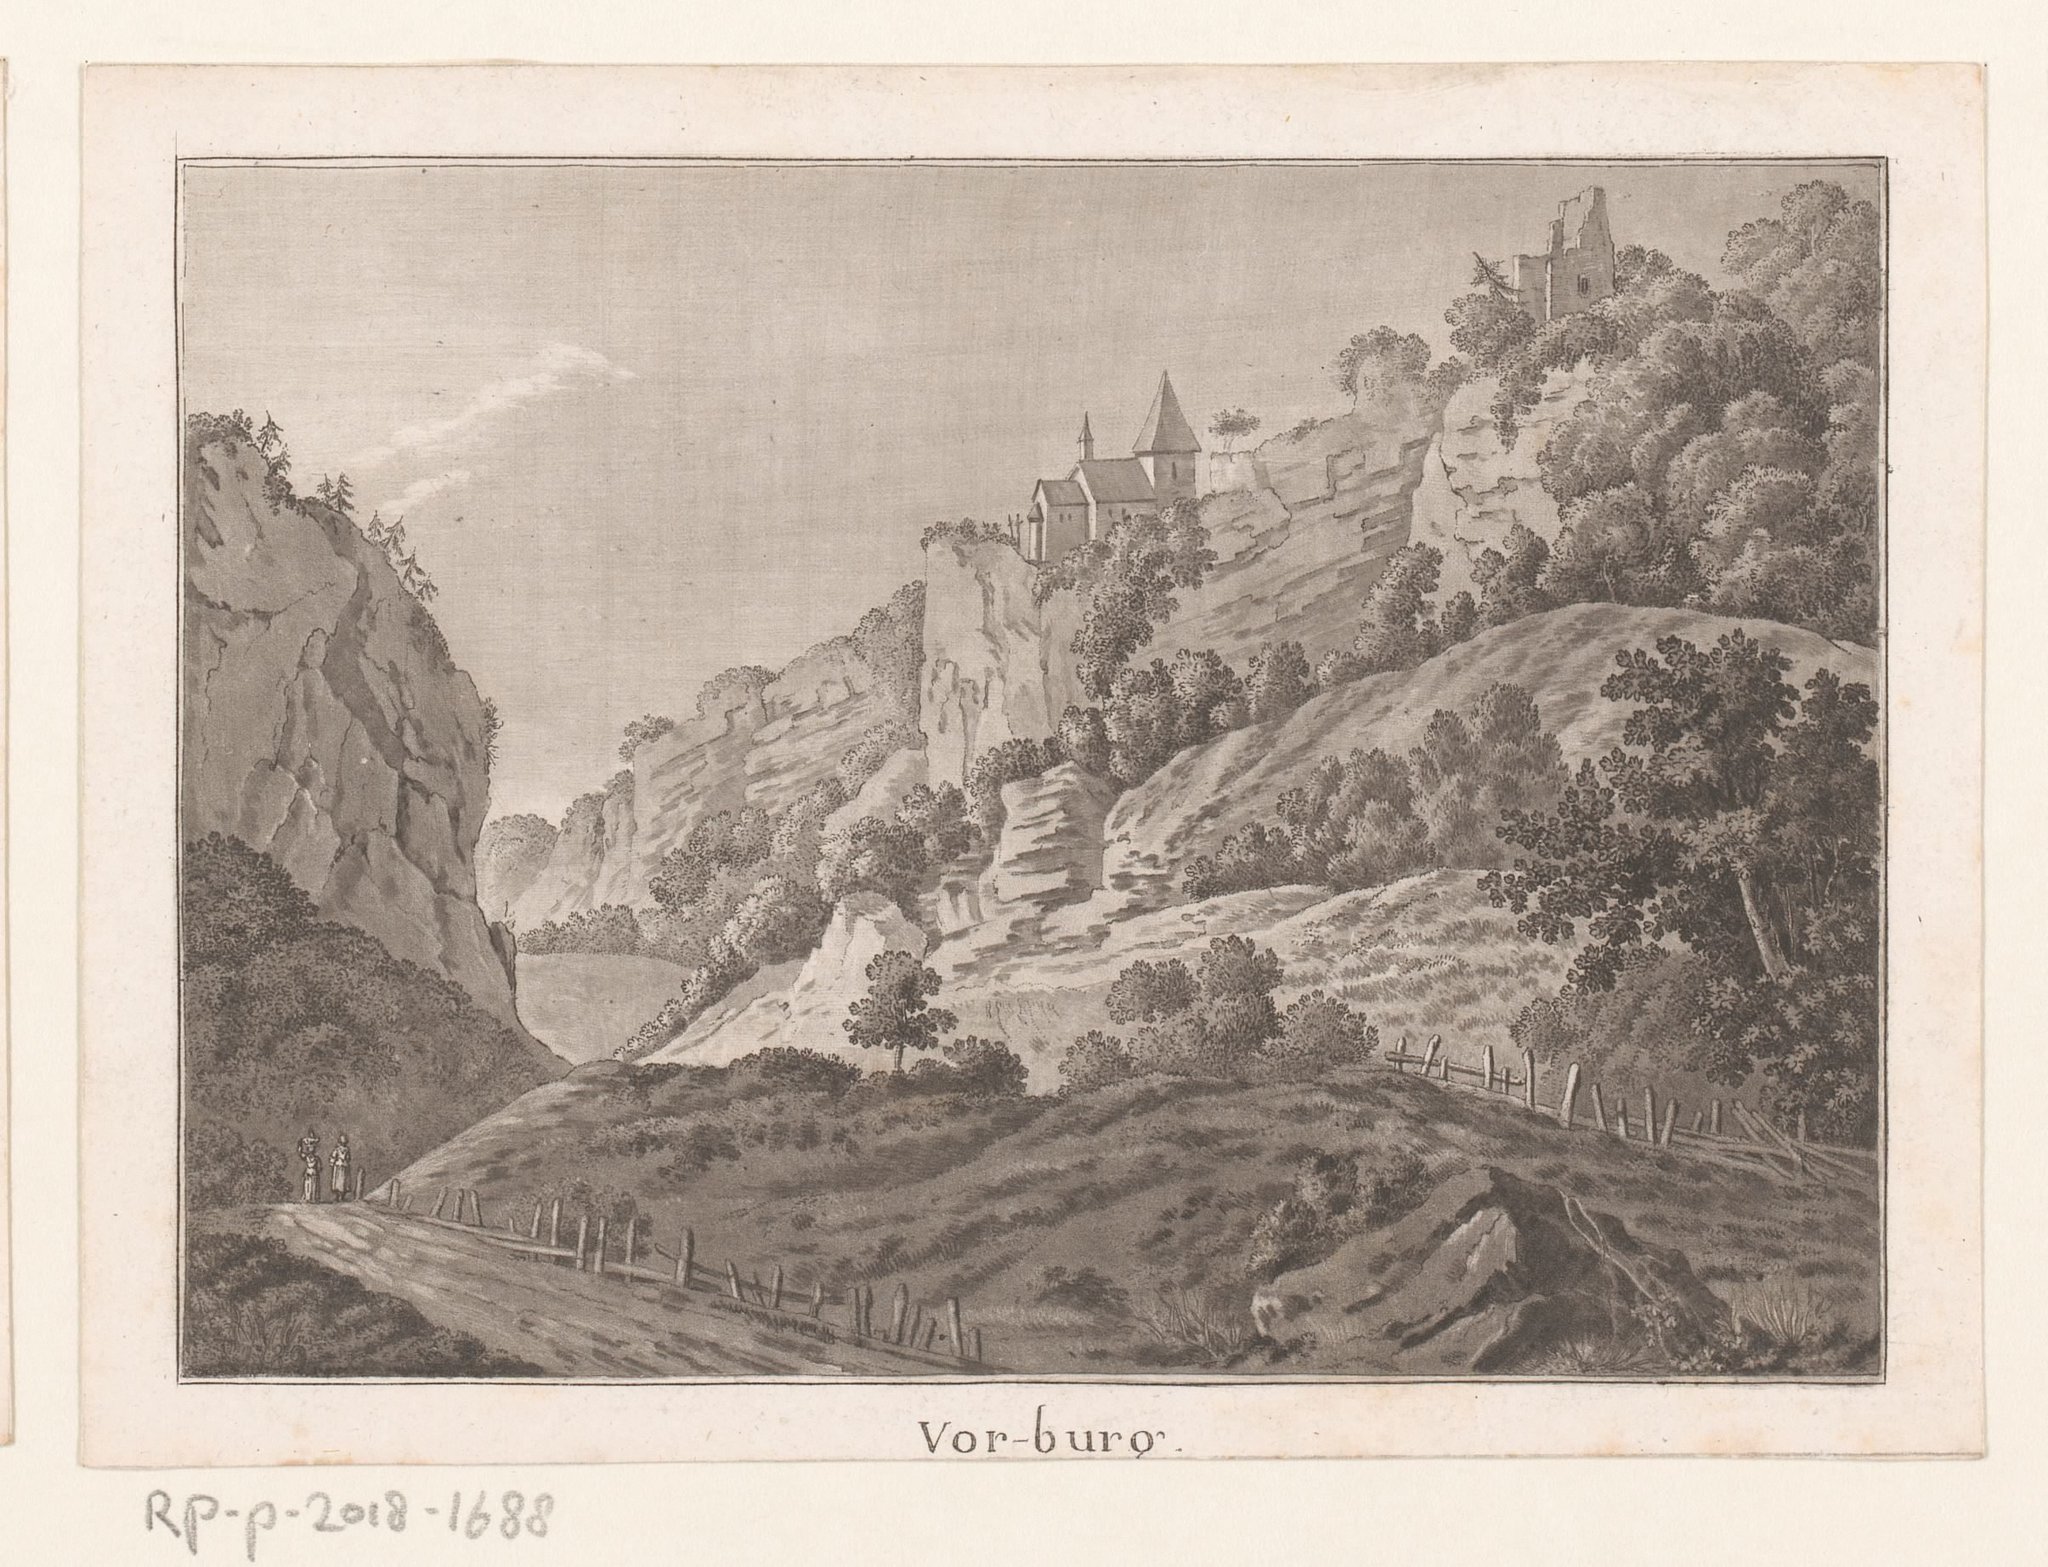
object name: print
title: Gezicht op de ruïne van Vorburg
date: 1810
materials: paper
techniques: aquatint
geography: amsterdam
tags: castle, ruin of a dwelling, house, castle, etc.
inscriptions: collector's mark: Lugt 2228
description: Prent ook gebruikt in: Promenade Pittoresque dans l'évêché de bâle aux bords de la Birs (...). Amsterdam: T.B. Groebe, 1710.